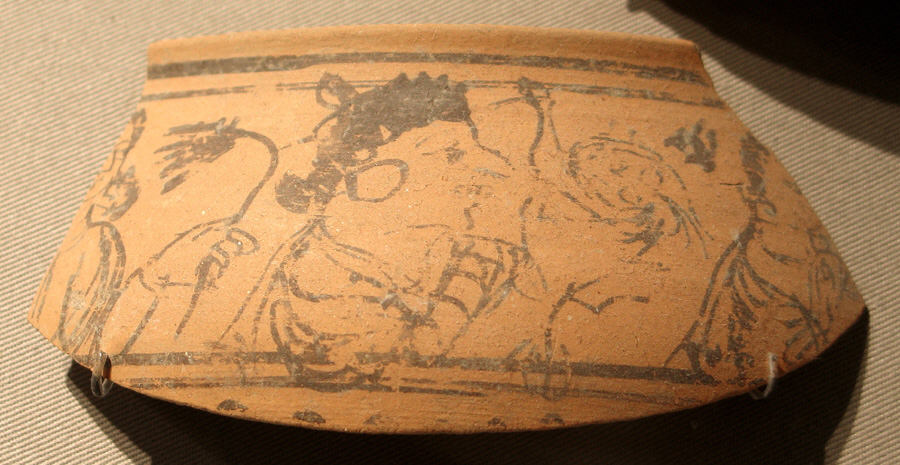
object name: shard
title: Shard with Figural Decoration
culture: pakistani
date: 301-500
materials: terracotta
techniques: painting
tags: gandhara